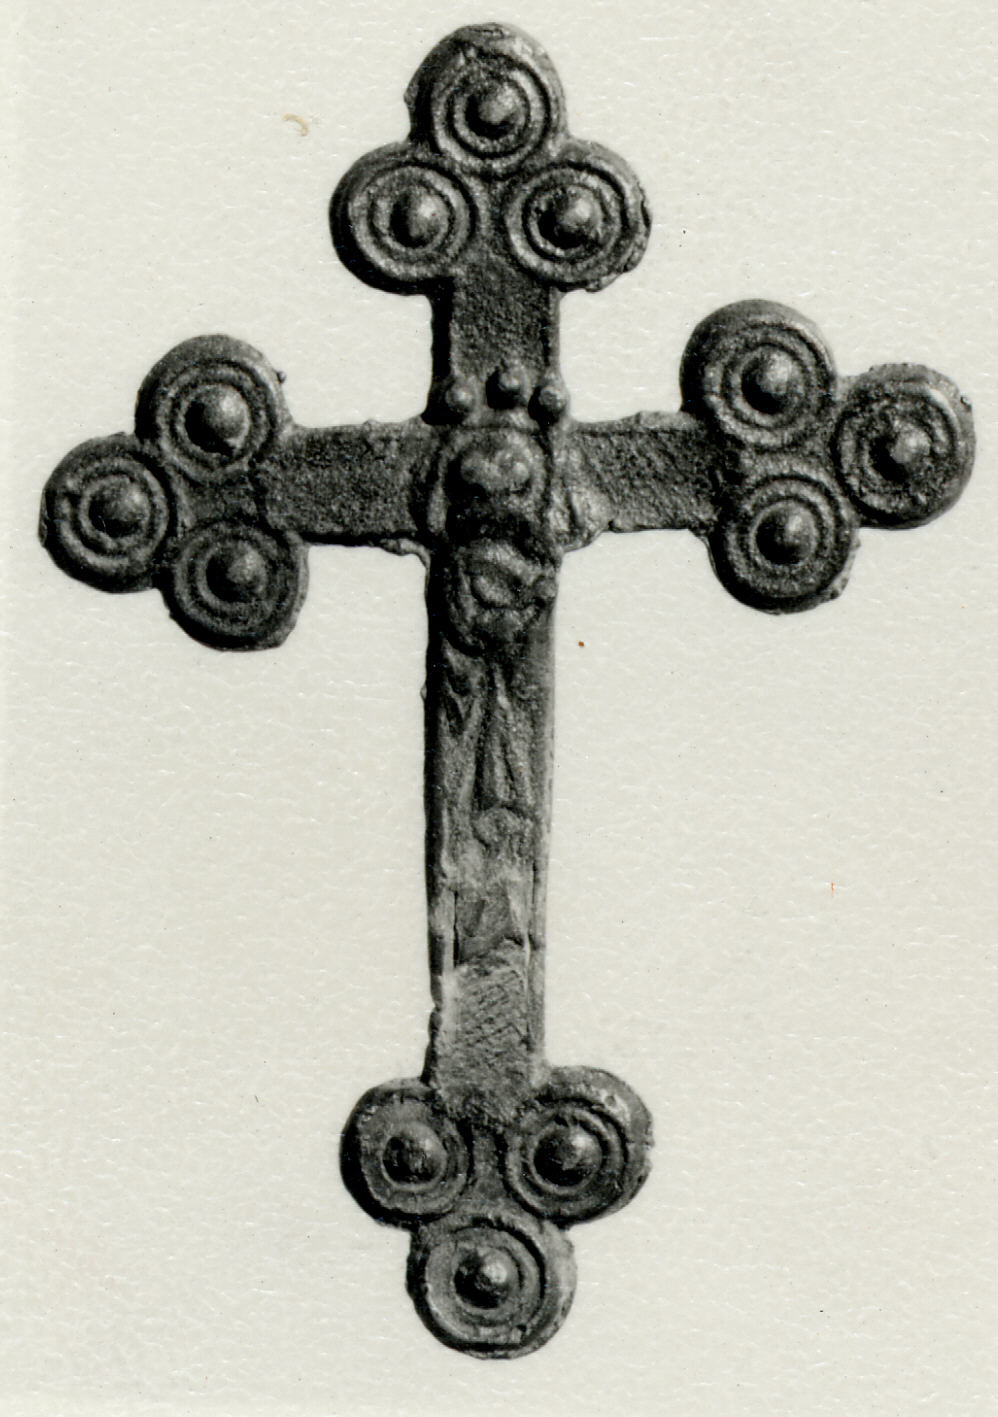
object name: pilgrim's badge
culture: french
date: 1401-1600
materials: lead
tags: cross